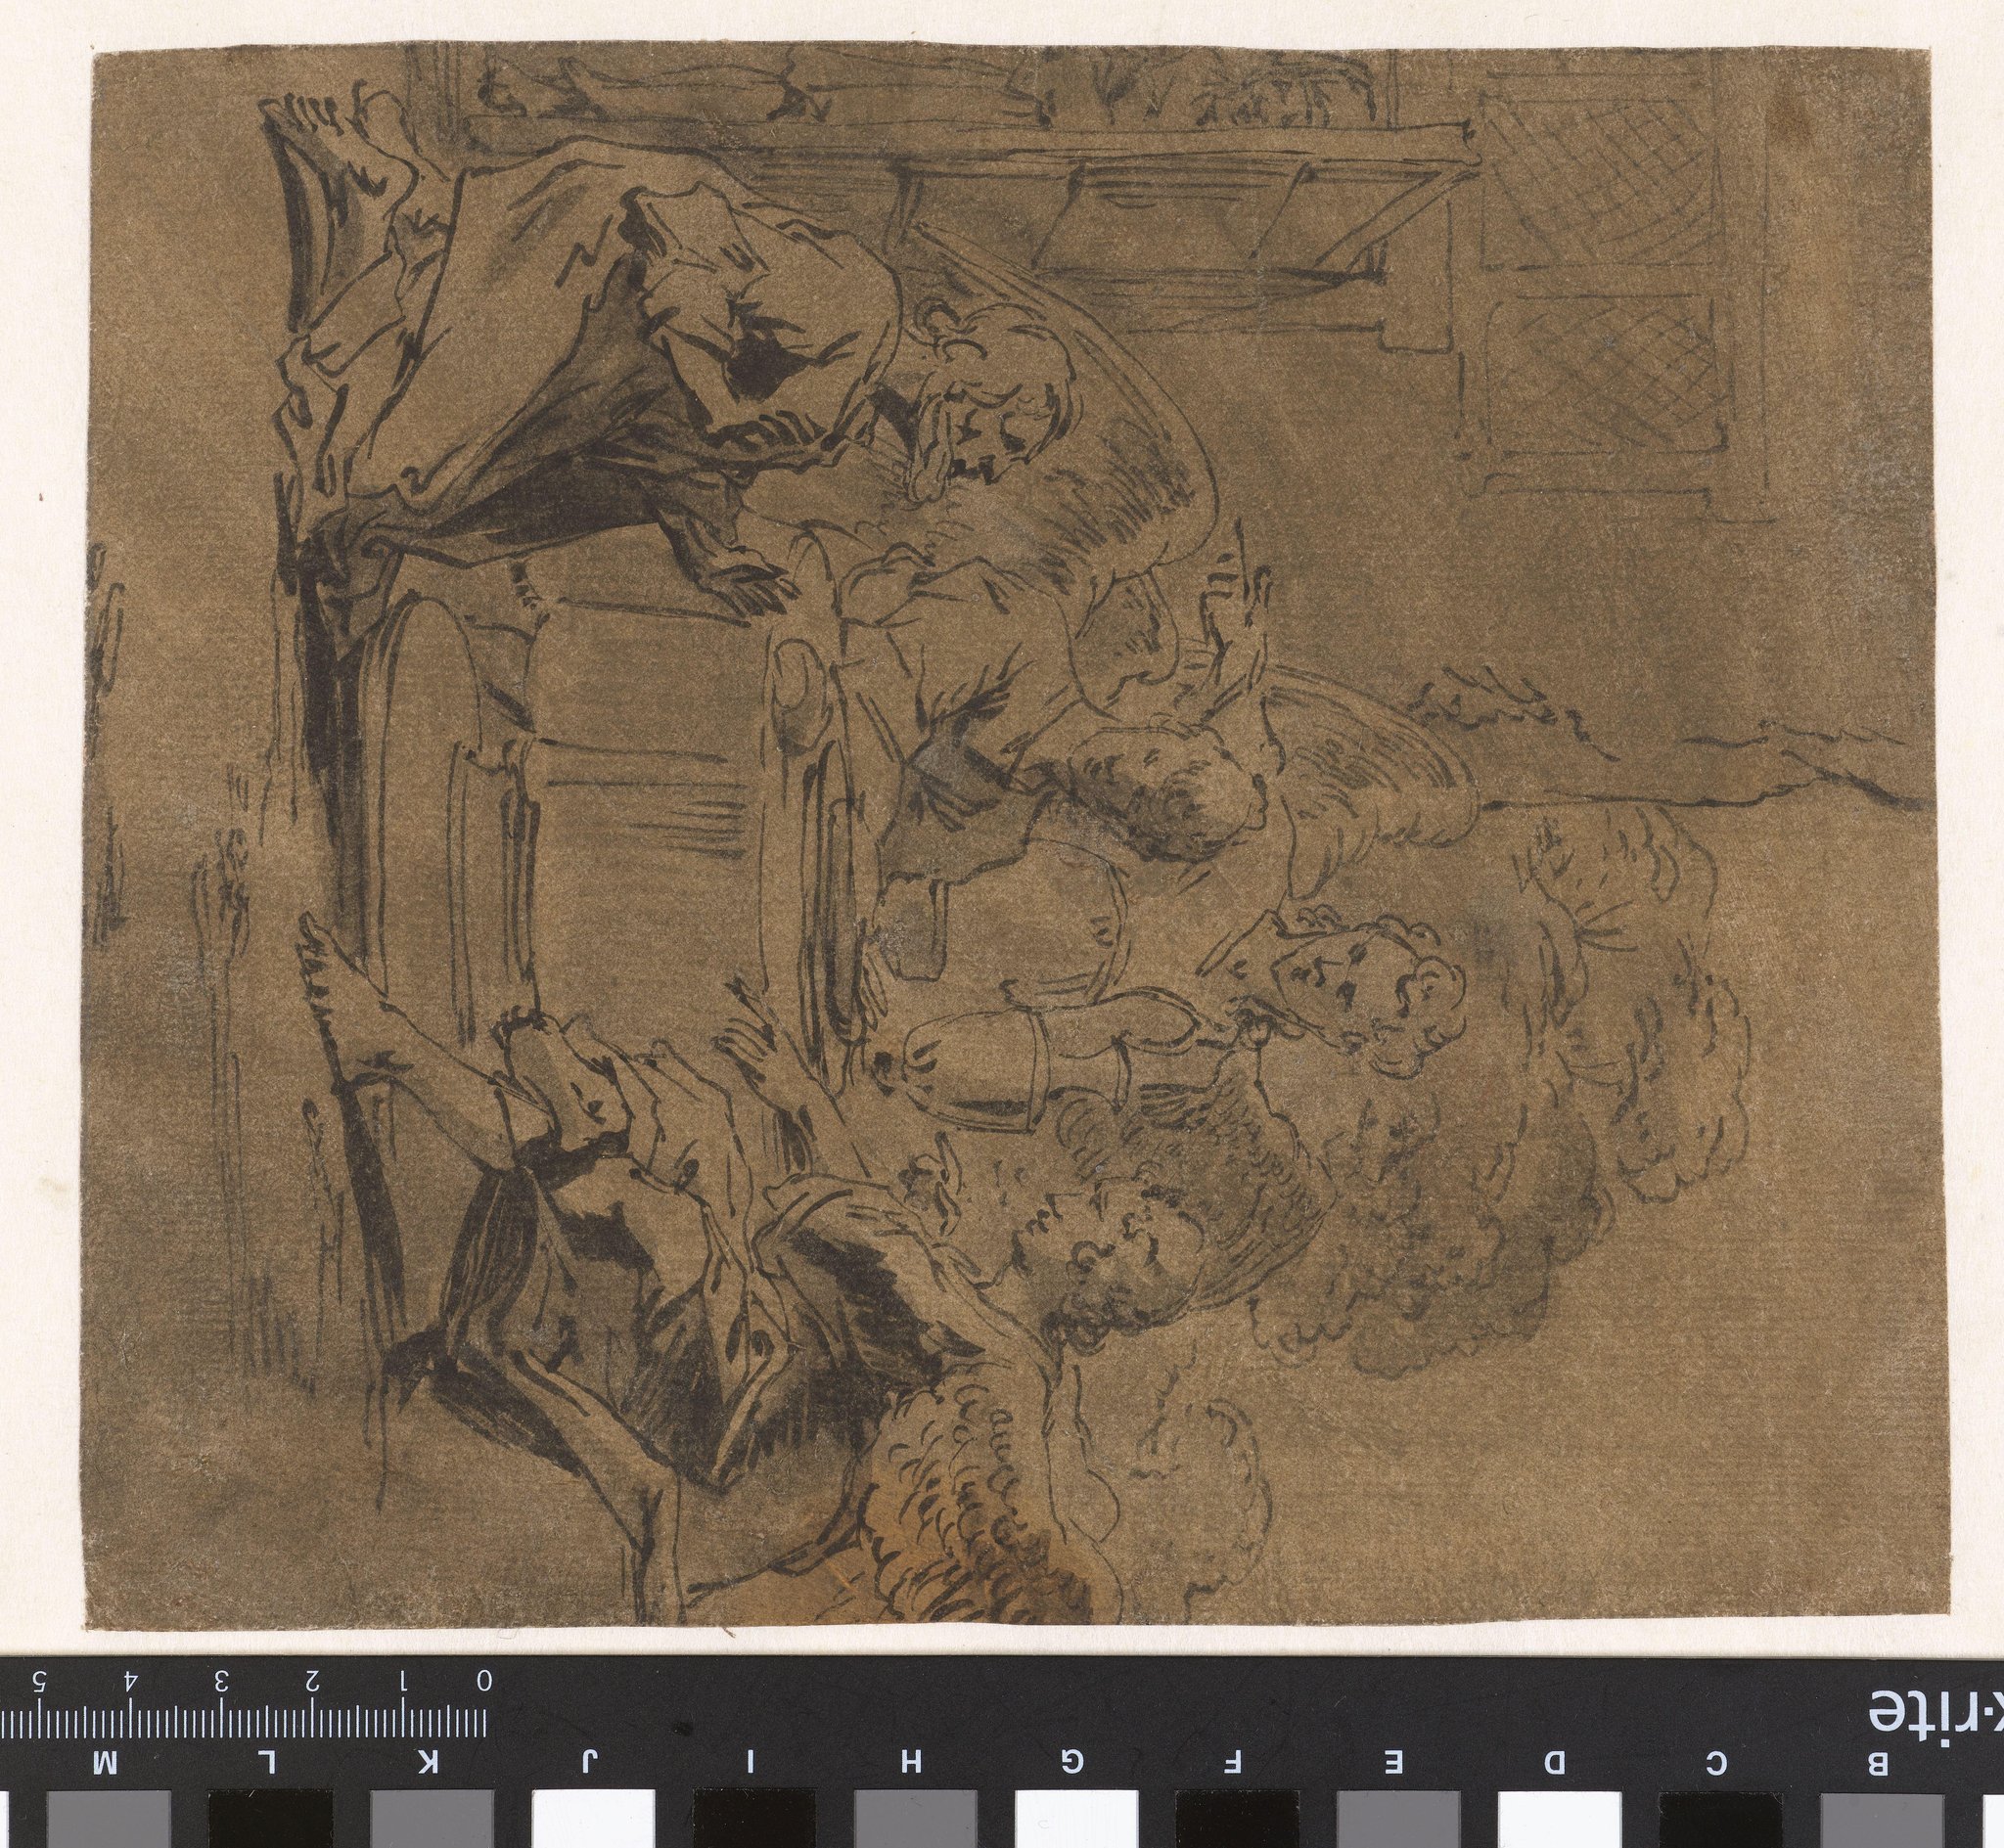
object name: drawing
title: De gastvrijheid van Abraham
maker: leonaert bramer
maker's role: draughtsman, painter, print maker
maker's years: 1596-1674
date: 1606-1674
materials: ink, paper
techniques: brush, pen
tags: abraham entertaining the three angels